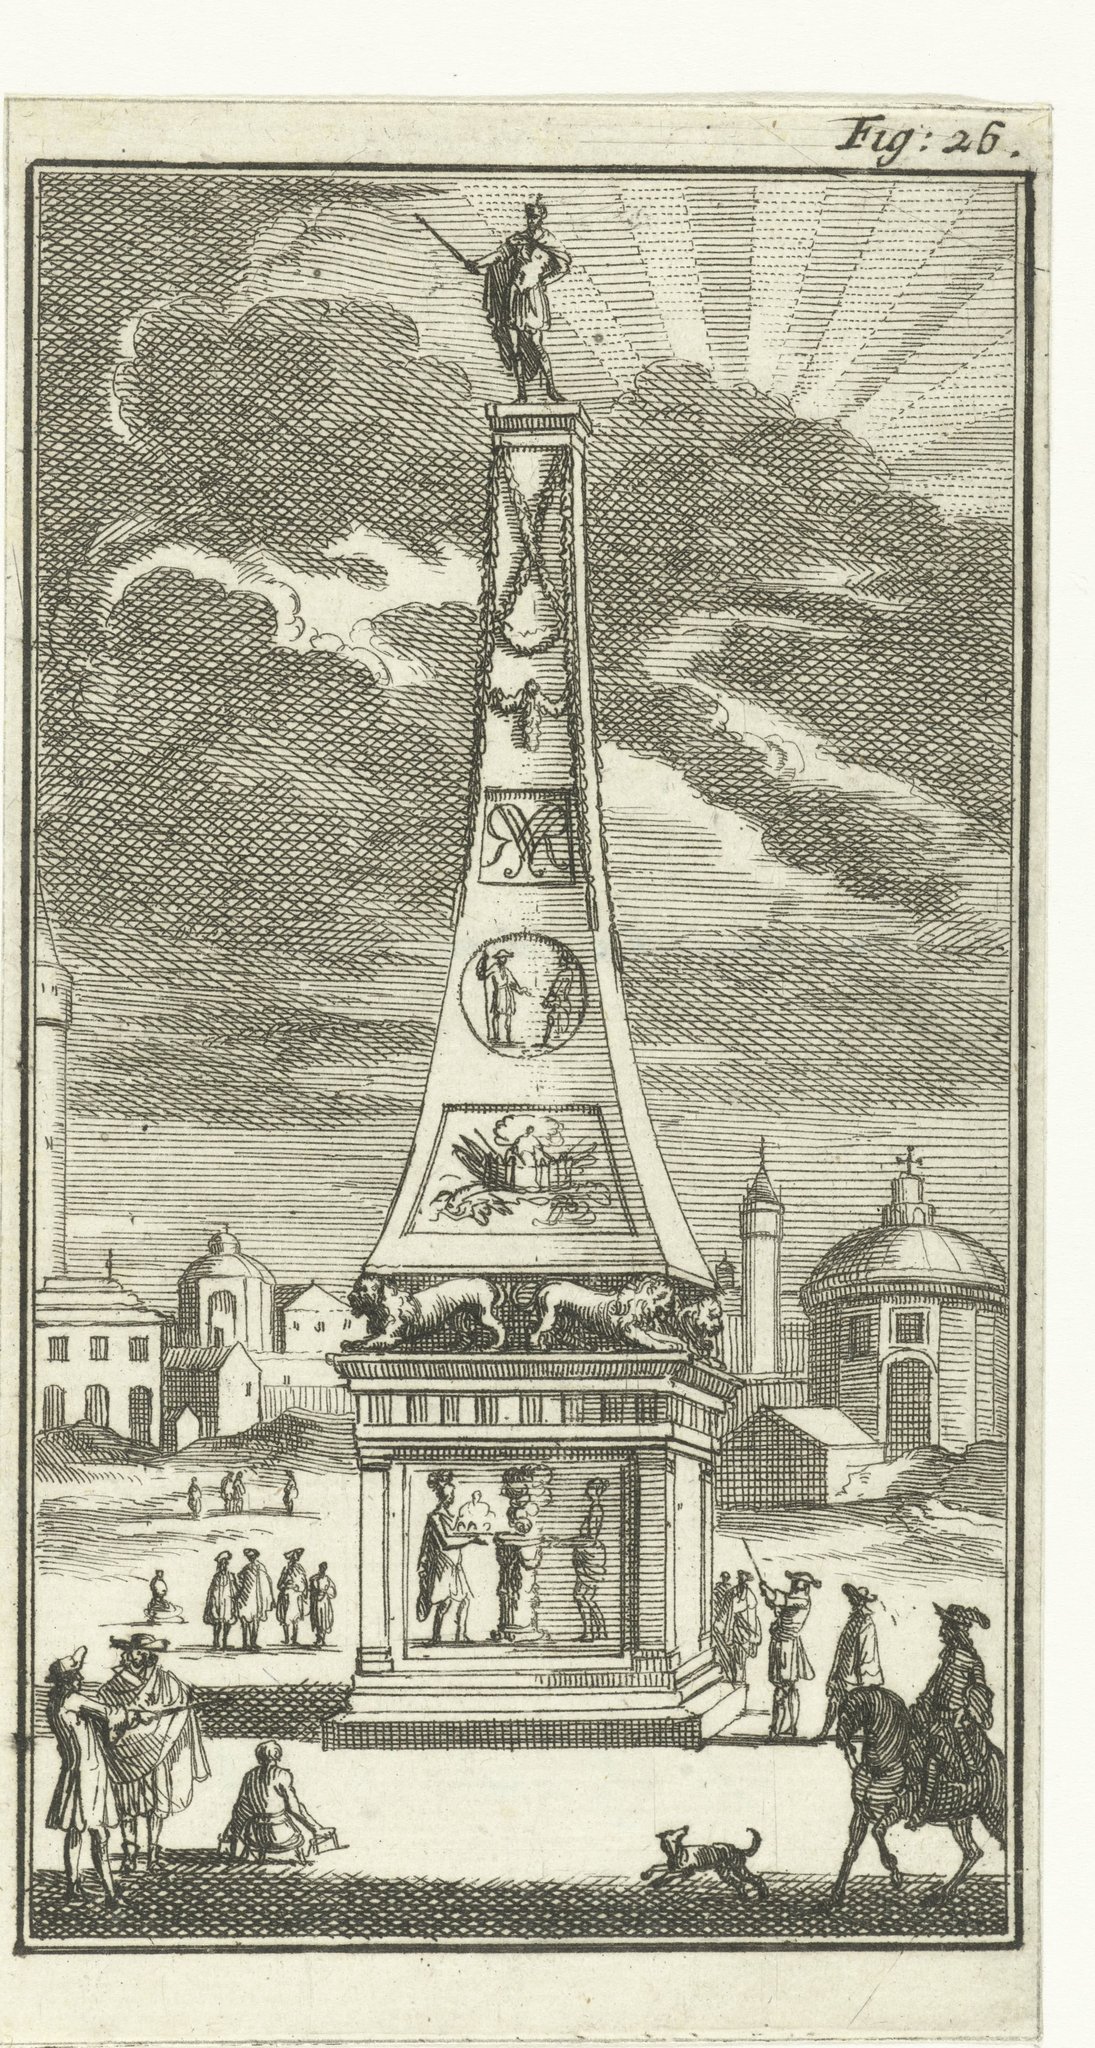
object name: print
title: Obelisk met het standbeeld van koning Willem III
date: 1691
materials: paper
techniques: etching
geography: the hague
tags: the hague, william iii (prince of orange and king of england, scotland, and ireland), obelisk, needle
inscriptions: collector's mark: Lugt 2228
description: Illustratie uit: Beeck, Barent. Le triomphe royal, où l'on voit dêscrits les arcs de triomphe (...) erigez à la Haye, à l'honneur de Guillaume III. Den Haag, 1691.